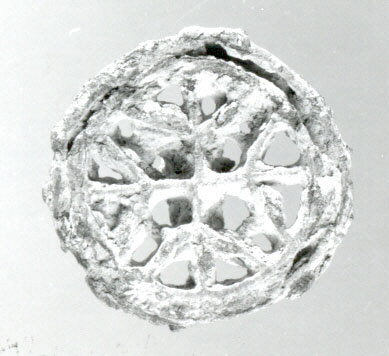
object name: stamp seal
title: Compartmented stamp seal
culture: bactria-margiana archaeological complex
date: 2333-1668 BCE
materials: copper alloy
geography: bactria-margiana